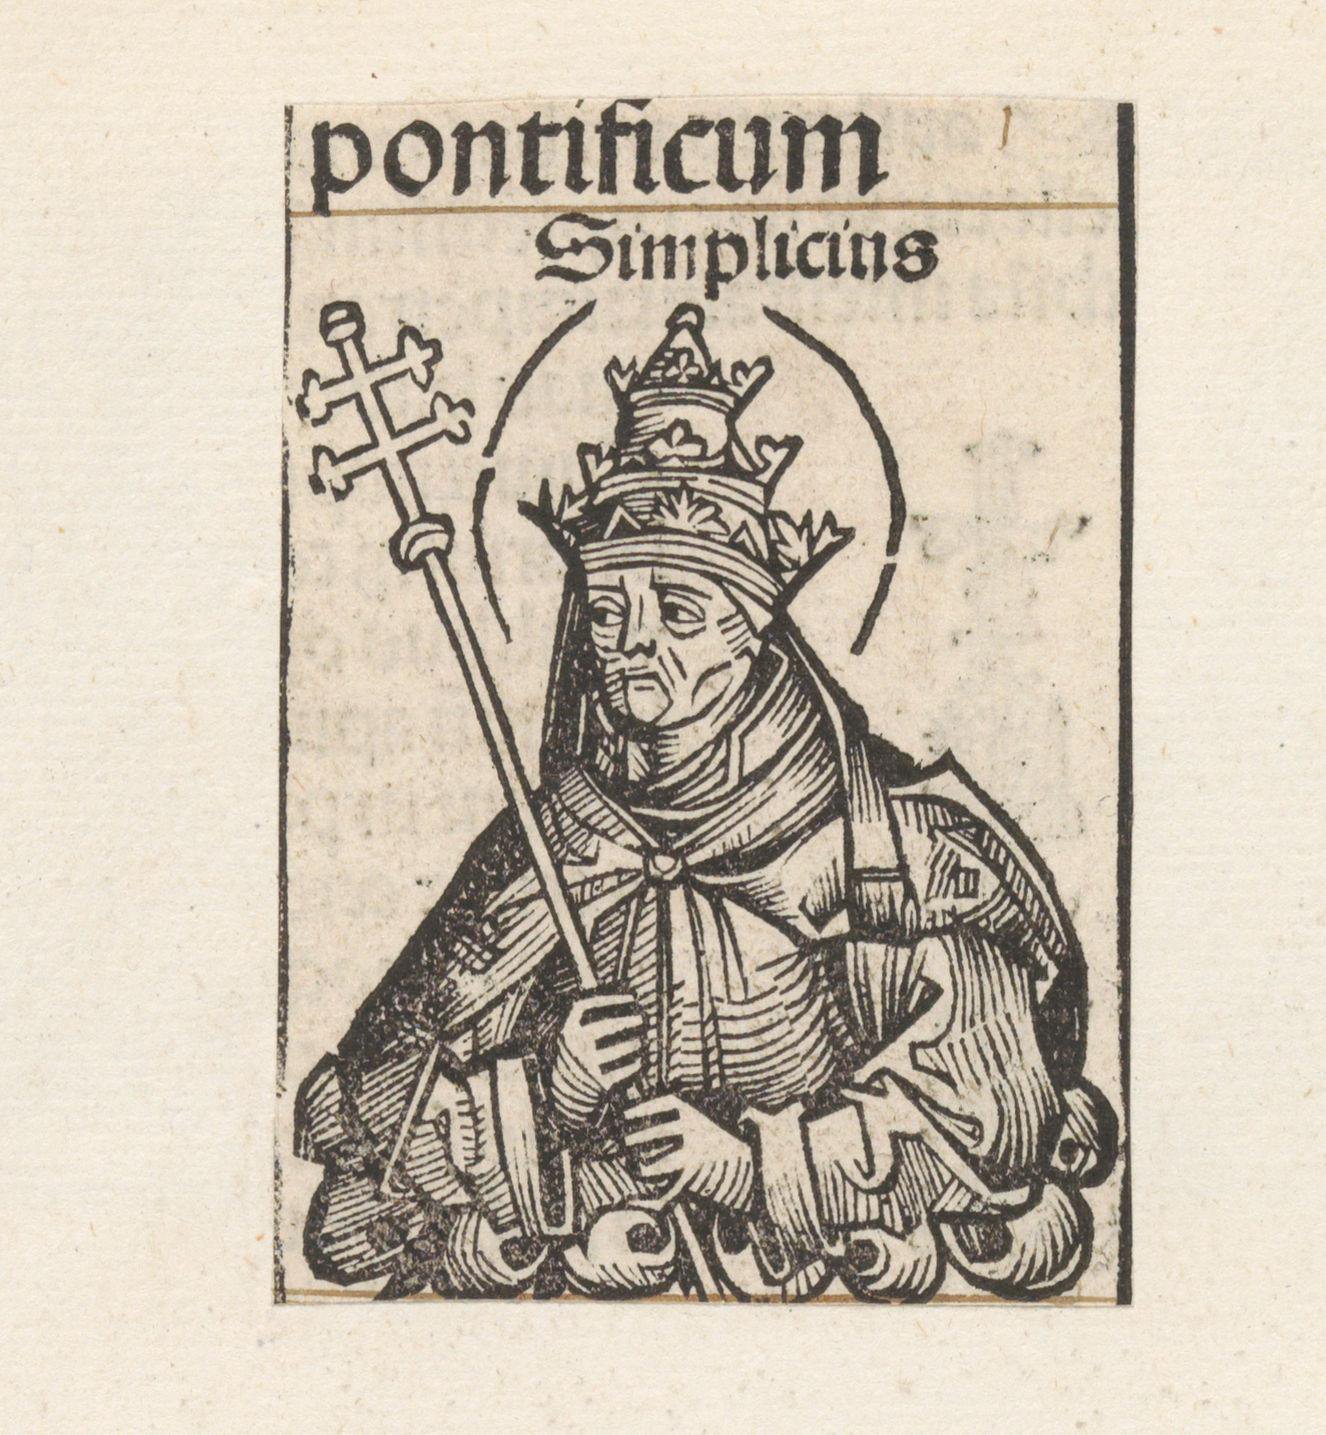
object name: book illustration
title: Liber Chronicarum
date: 1493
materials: paper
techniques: letterpress printing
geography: nuremberg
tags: tivoli, pope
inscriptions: inscription: ‘1’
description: Een bloemkelk met een paus. Hij draagt een tiara en heeft een staf met een dubbel kruis in zijn handen. De nimbus om zijn hoofd vertelt dat deze paus heilig is verklaard. De voorstelling is onderdeel van de opeenvolging pausen in de Liber Chronicarum. De tekst identificeert de man als paus Simplicius. De prent maakt deel uit van een album.